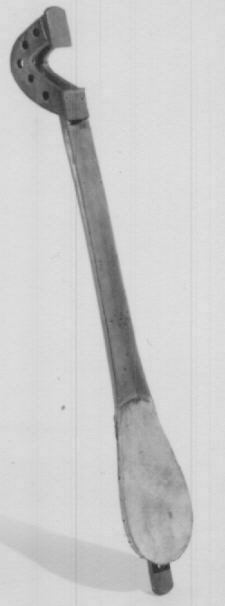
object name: qanbūs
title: Qanbus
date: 1867-1900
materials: wood